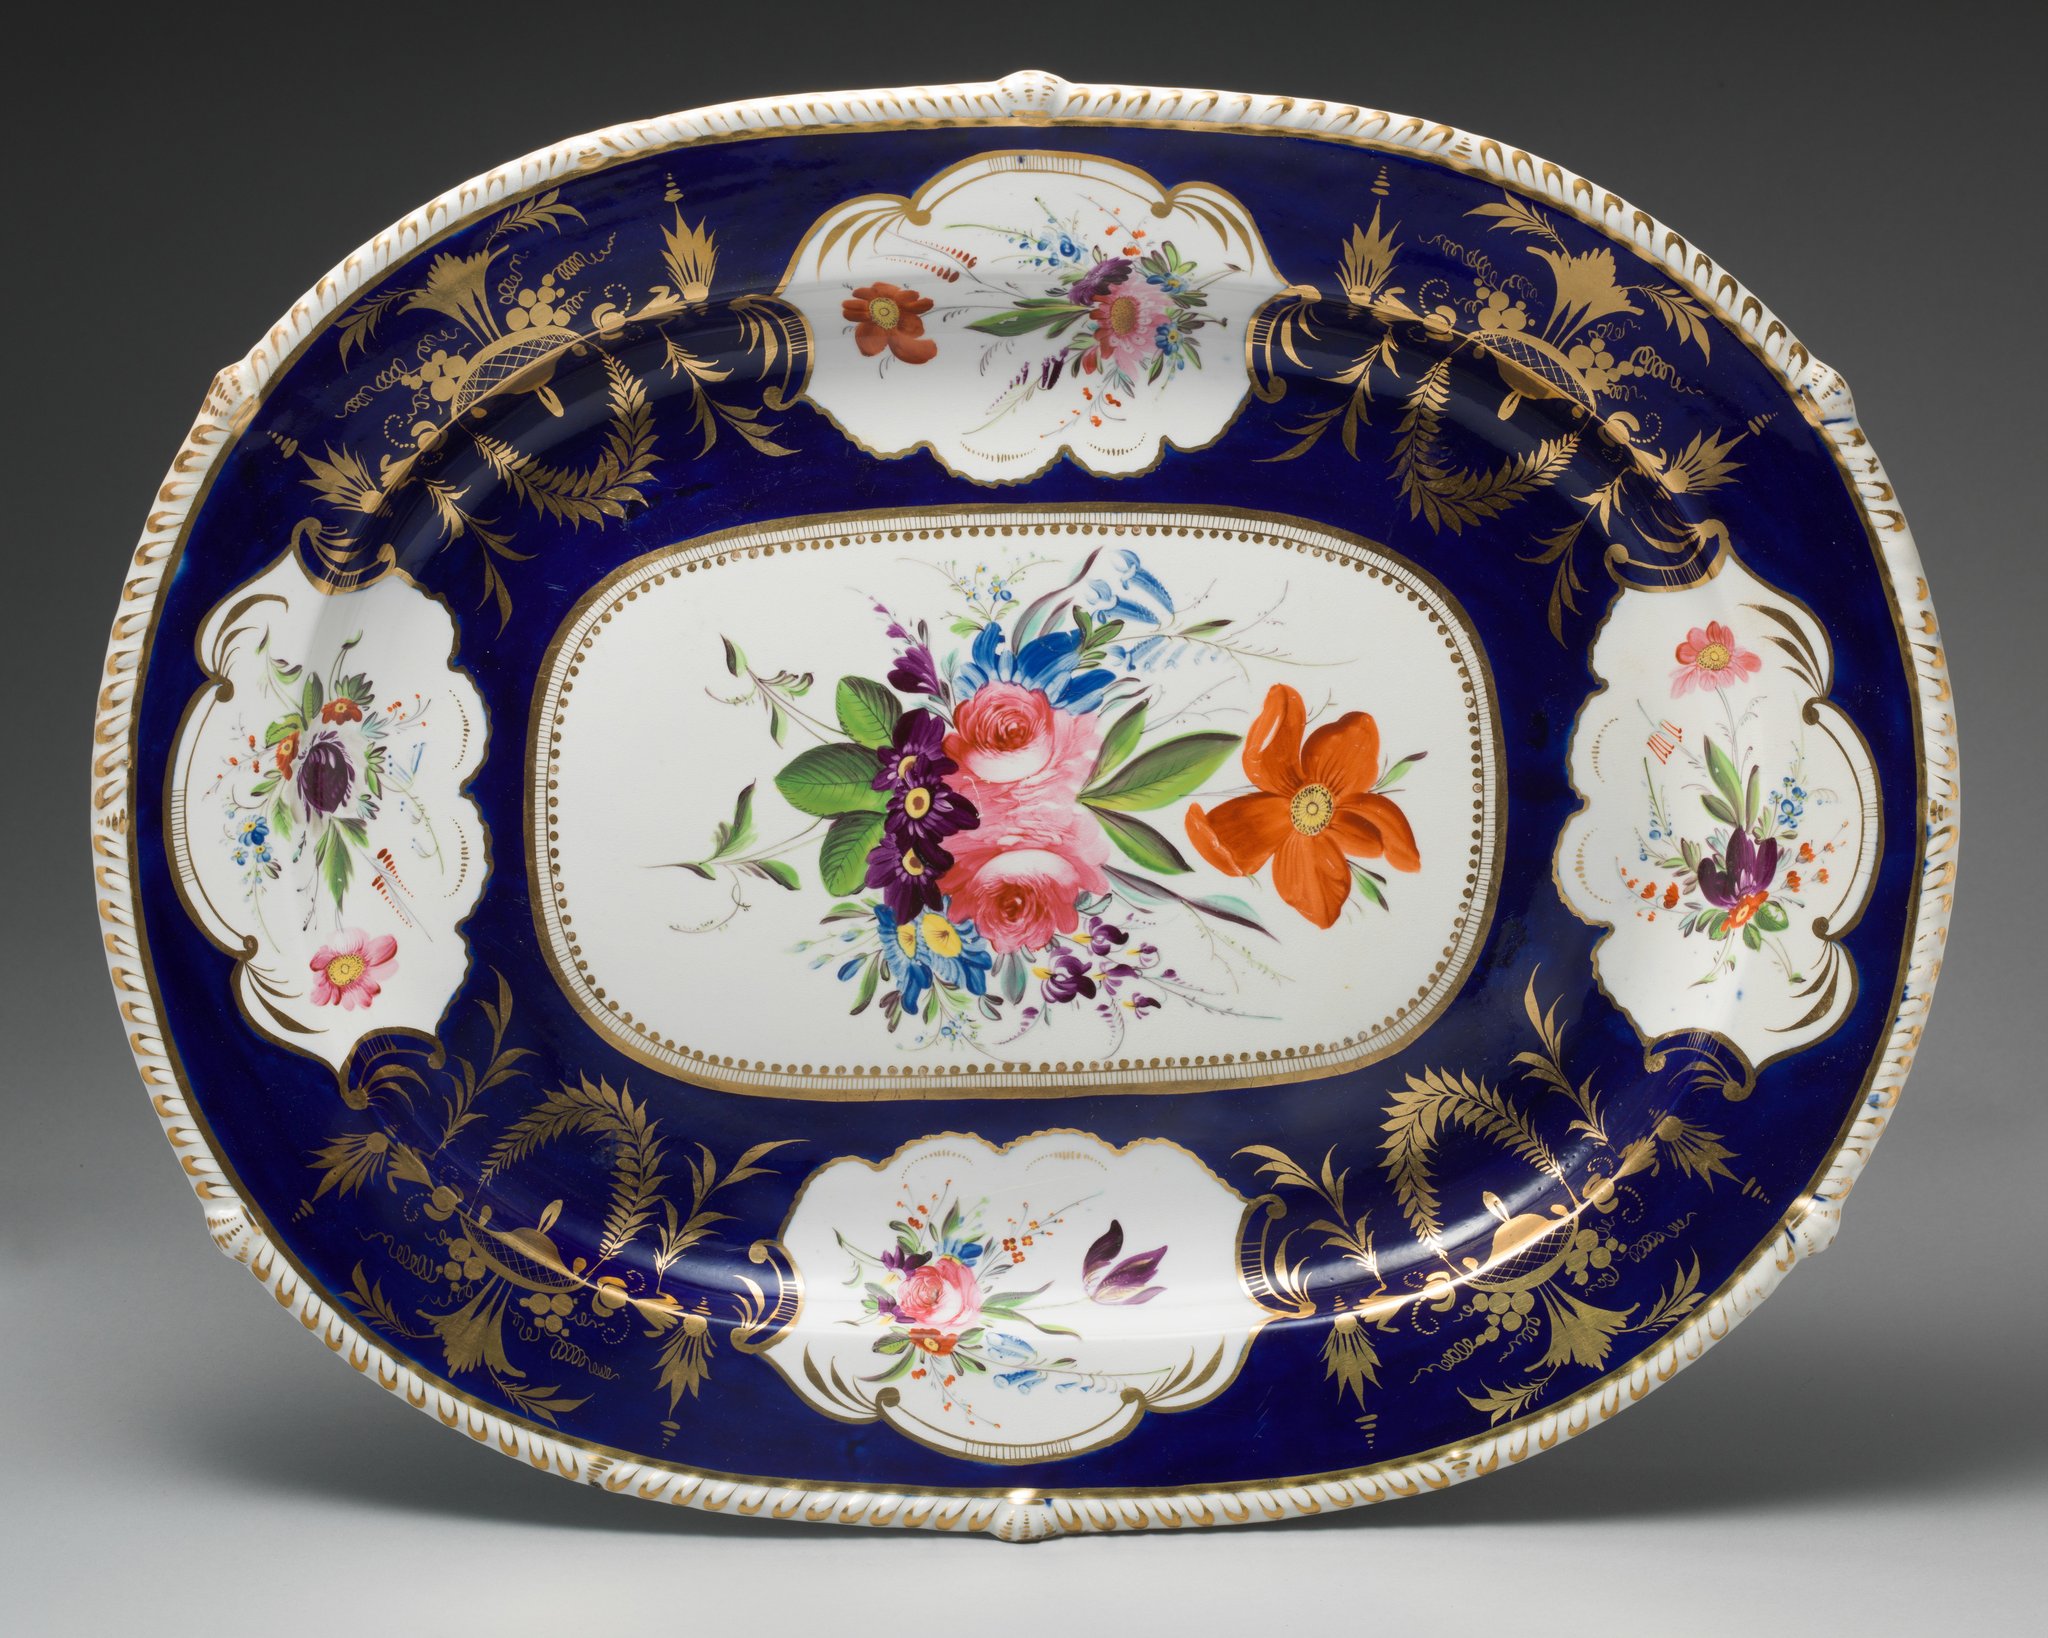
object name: platter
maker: crown derby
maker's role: maker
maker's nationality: british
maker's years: 1750-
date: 1814-1830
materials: soft paste porcelain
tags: flowers